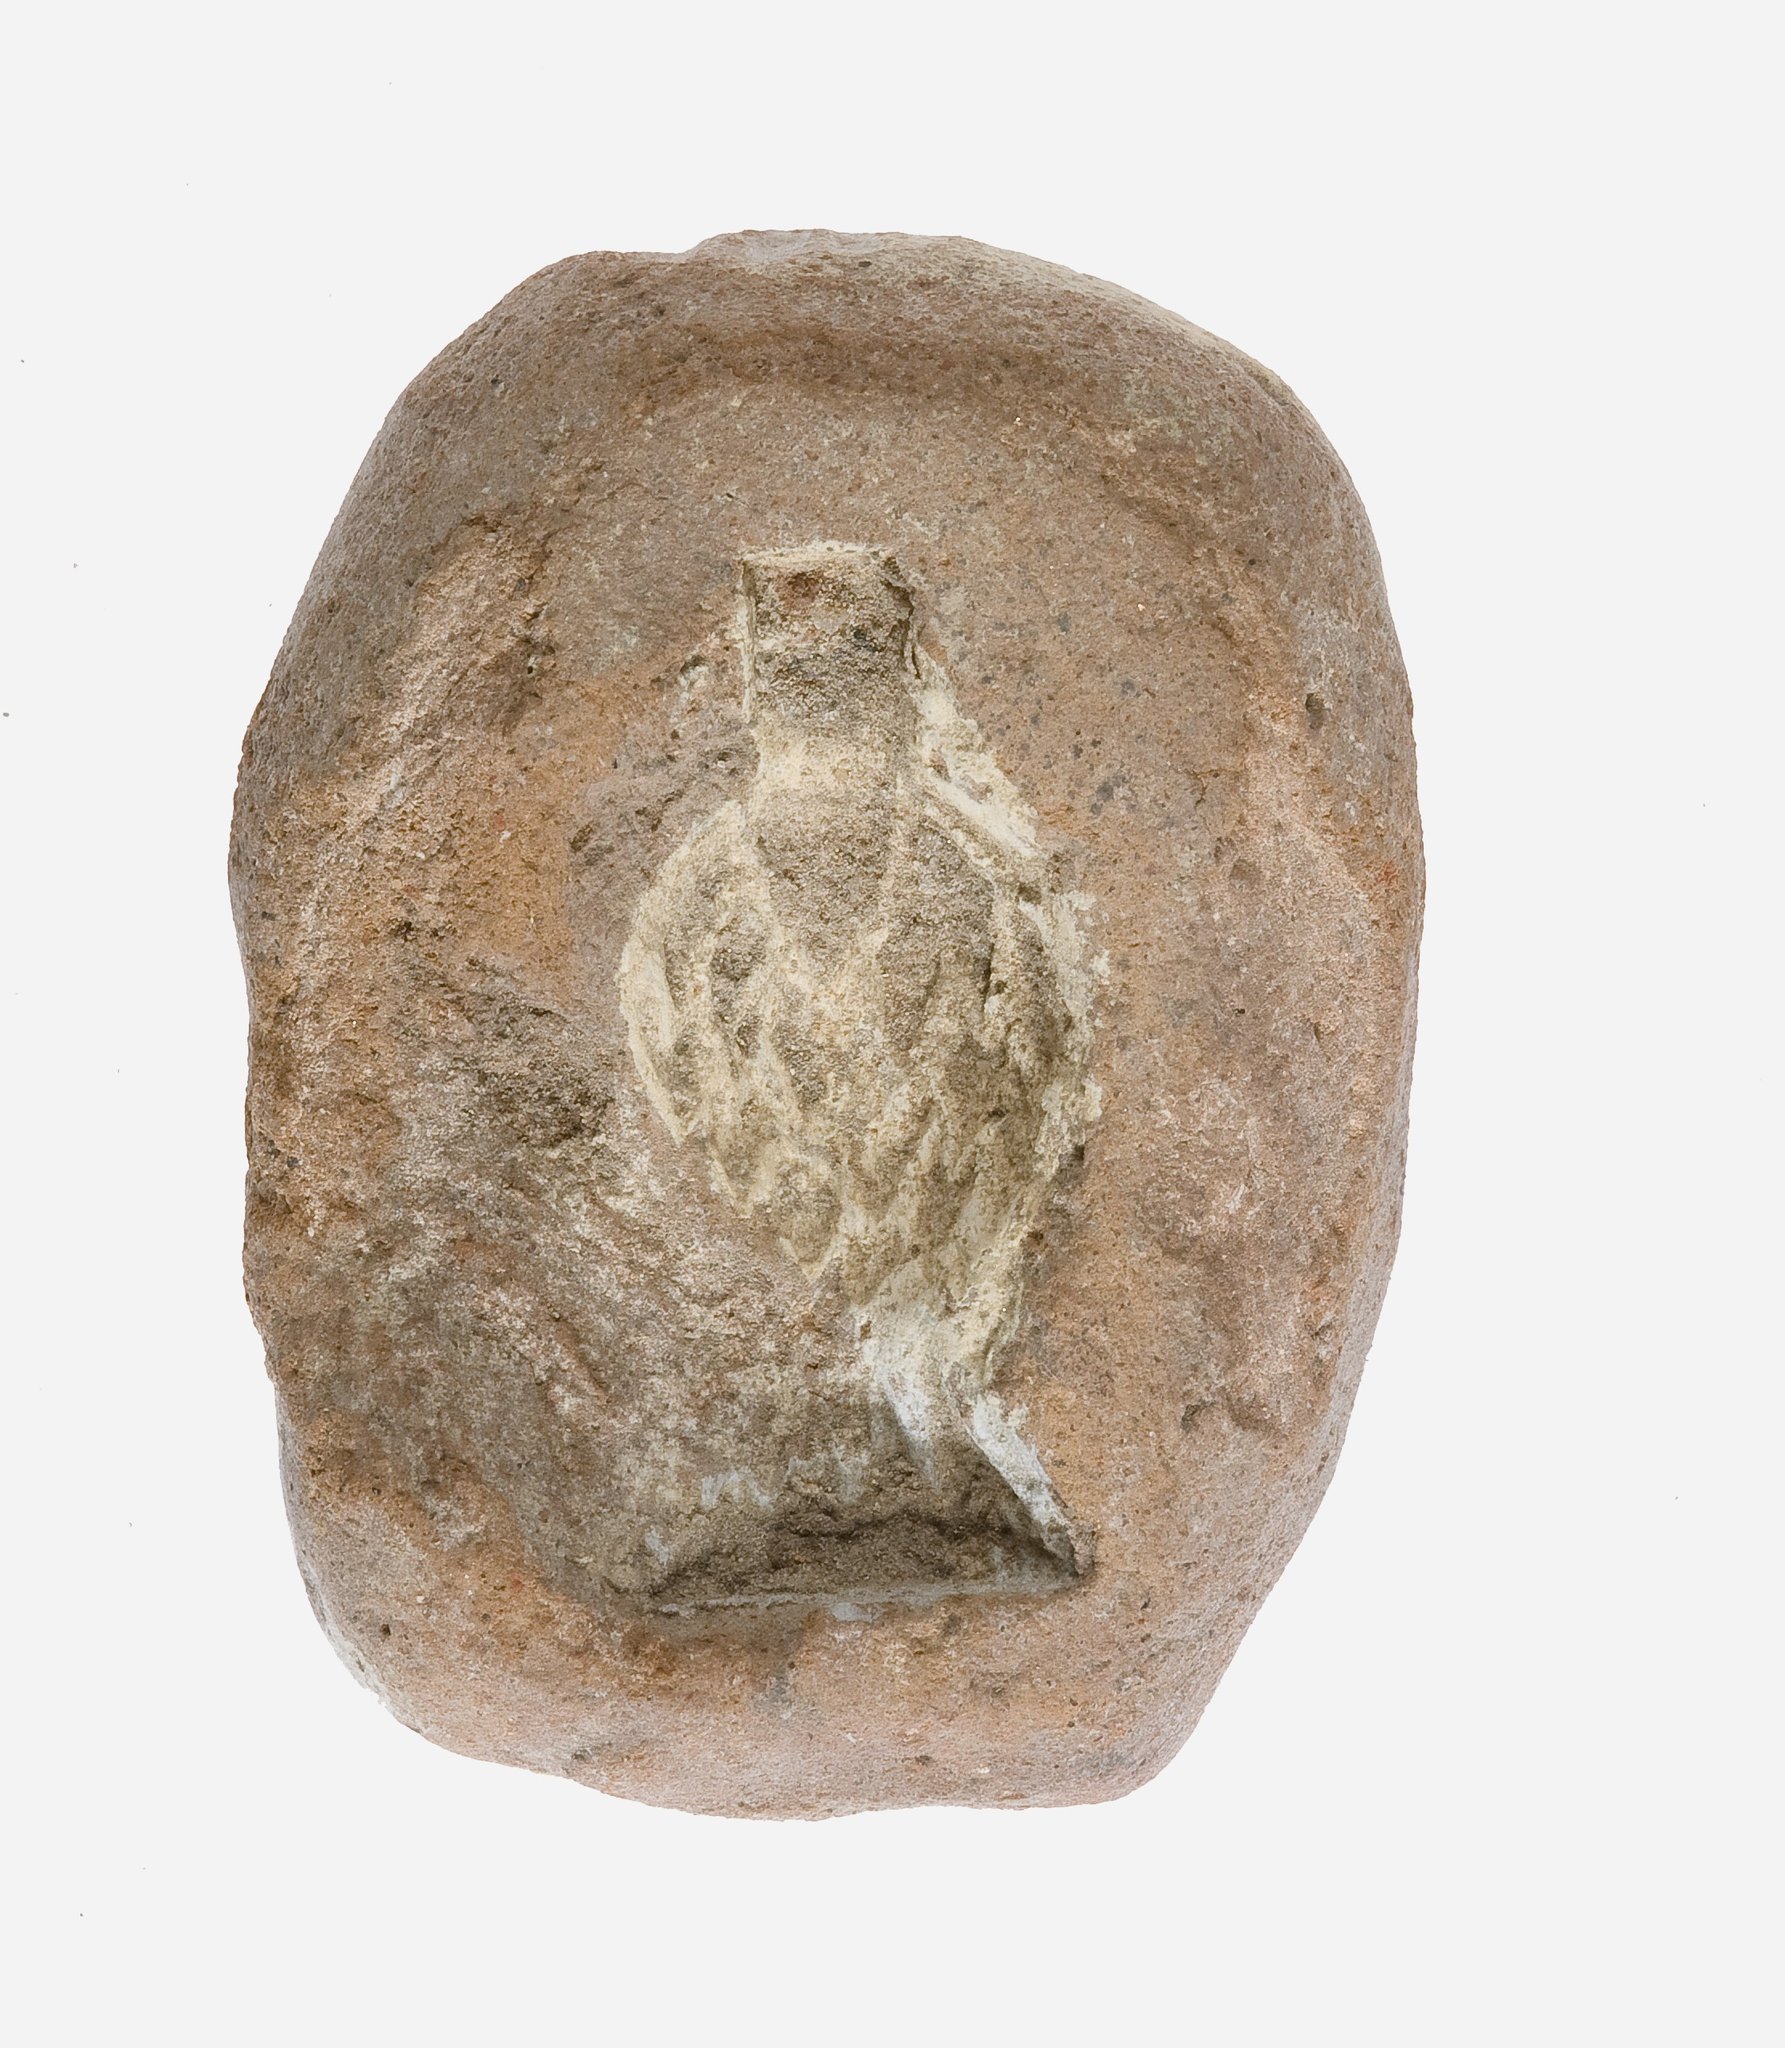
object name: mold, cornflower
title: Mold for a Cornflower Bead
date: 1390-1352 BCE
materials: pottery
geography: egypt